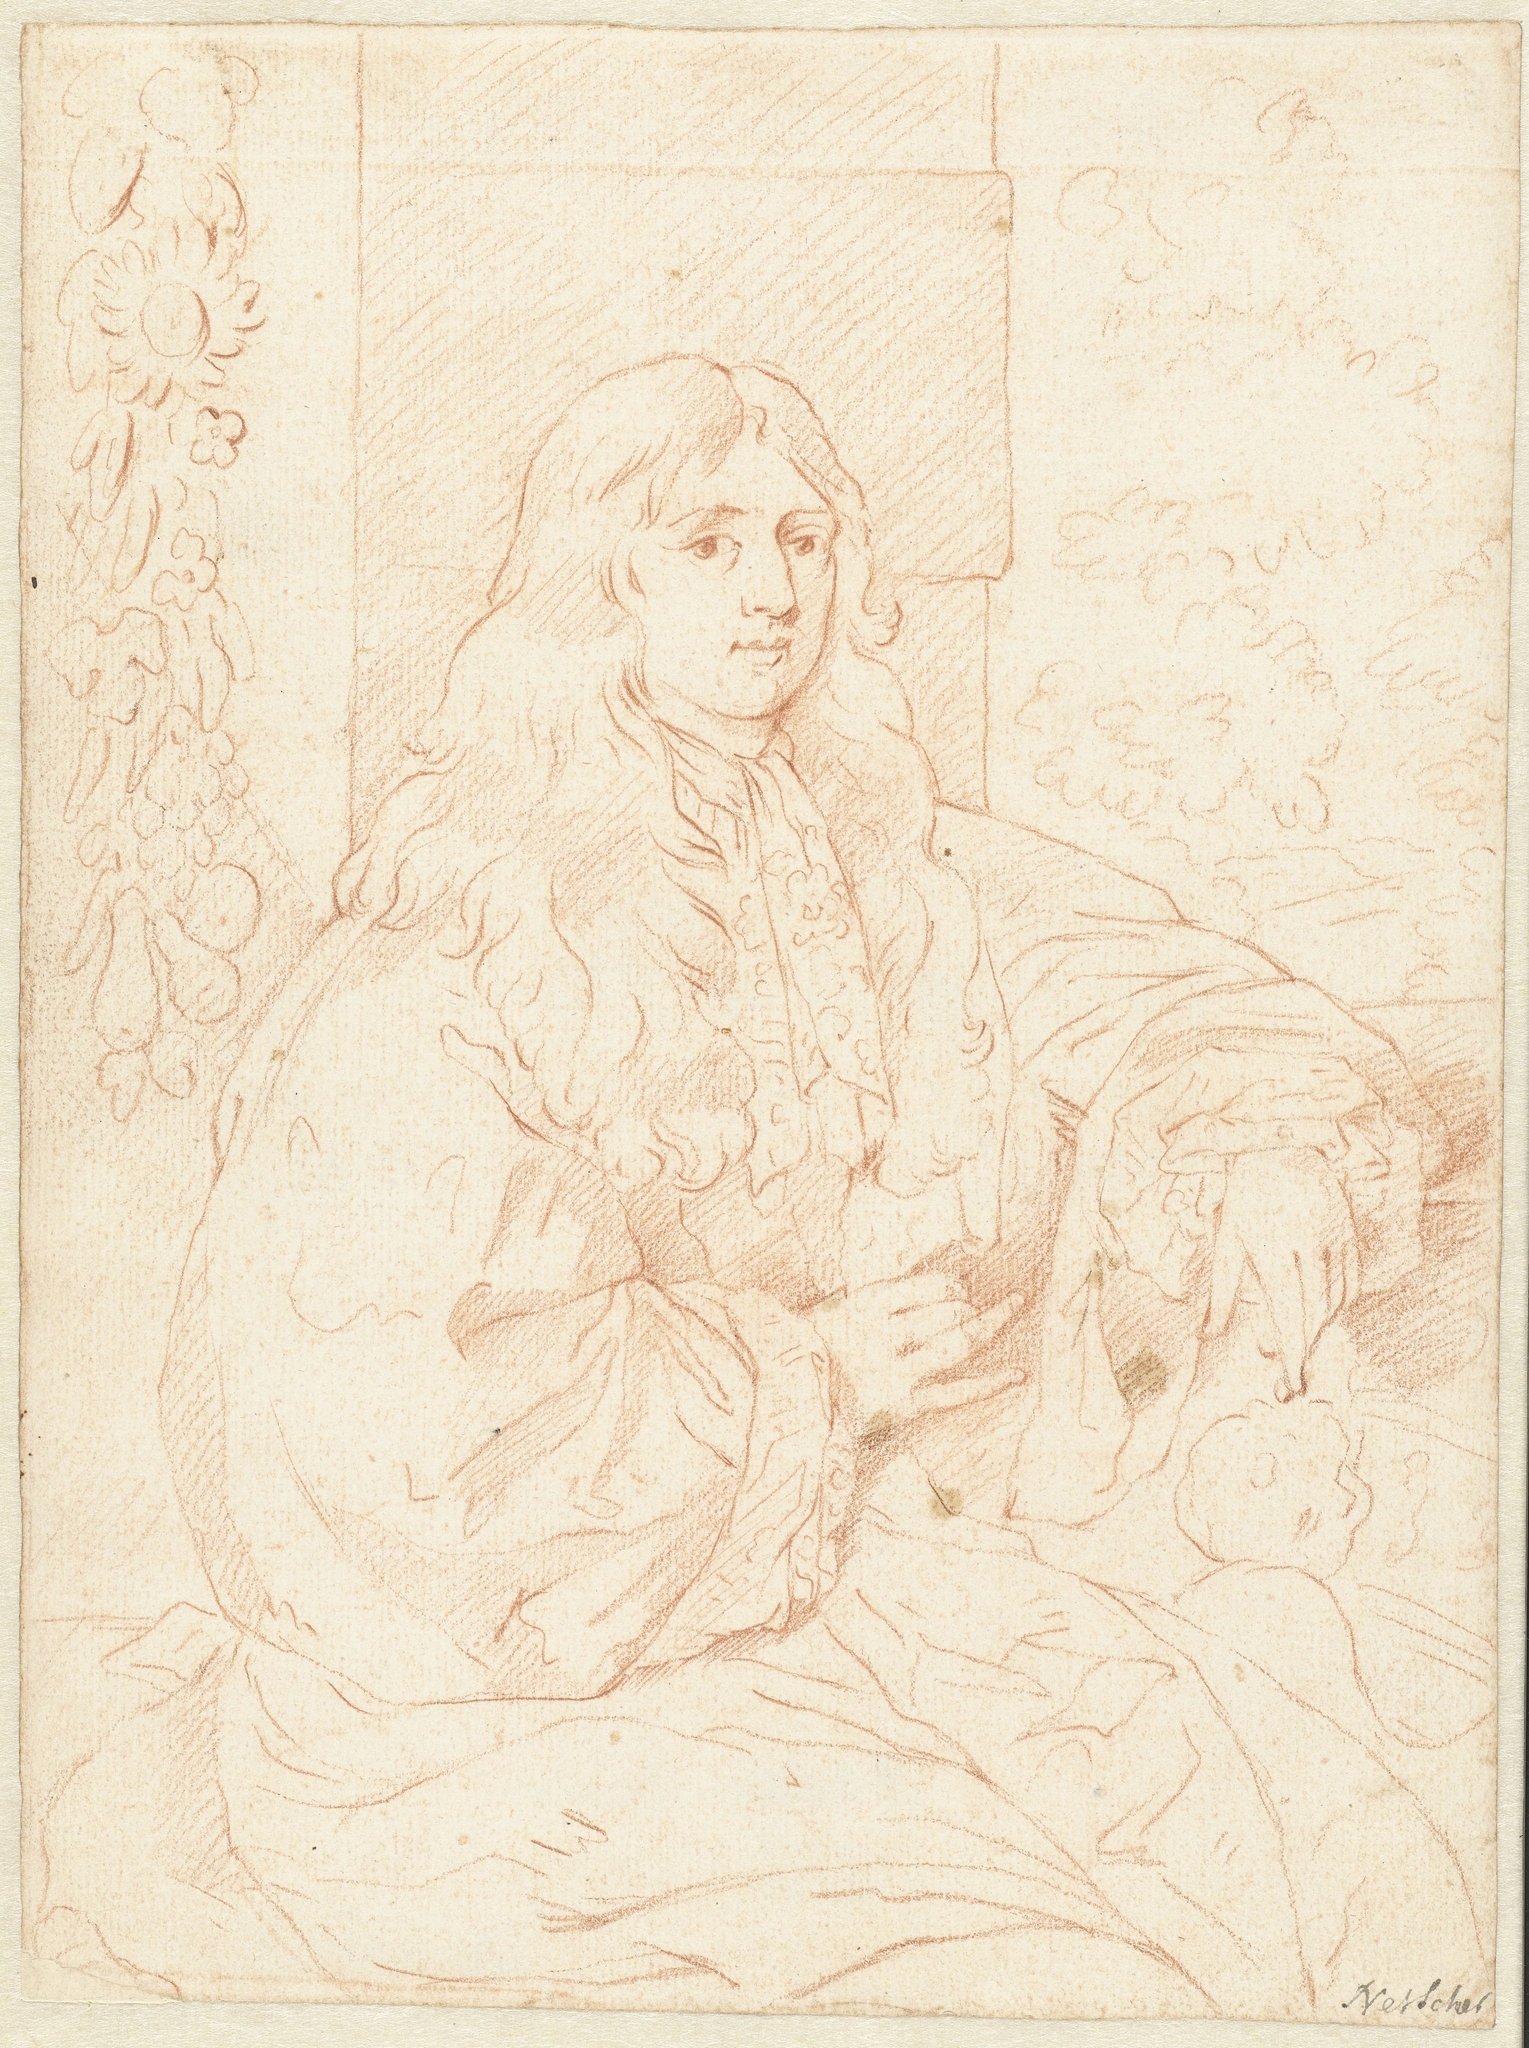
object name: drawing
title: Portret van Caspar Netscher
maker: theodorus netscher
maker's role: draughtsman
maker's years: 1661-1728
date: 1671-1732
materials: chalk, paper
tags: the hague, painter, print maker, draughtsman, caspar netscher, historical persons, portrait, self-portrait of painter, portrait, self-portrait of artist, portrait, self-portrait of draughtsman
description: Portret van Caspar Netscher, kniestuk, zittend.